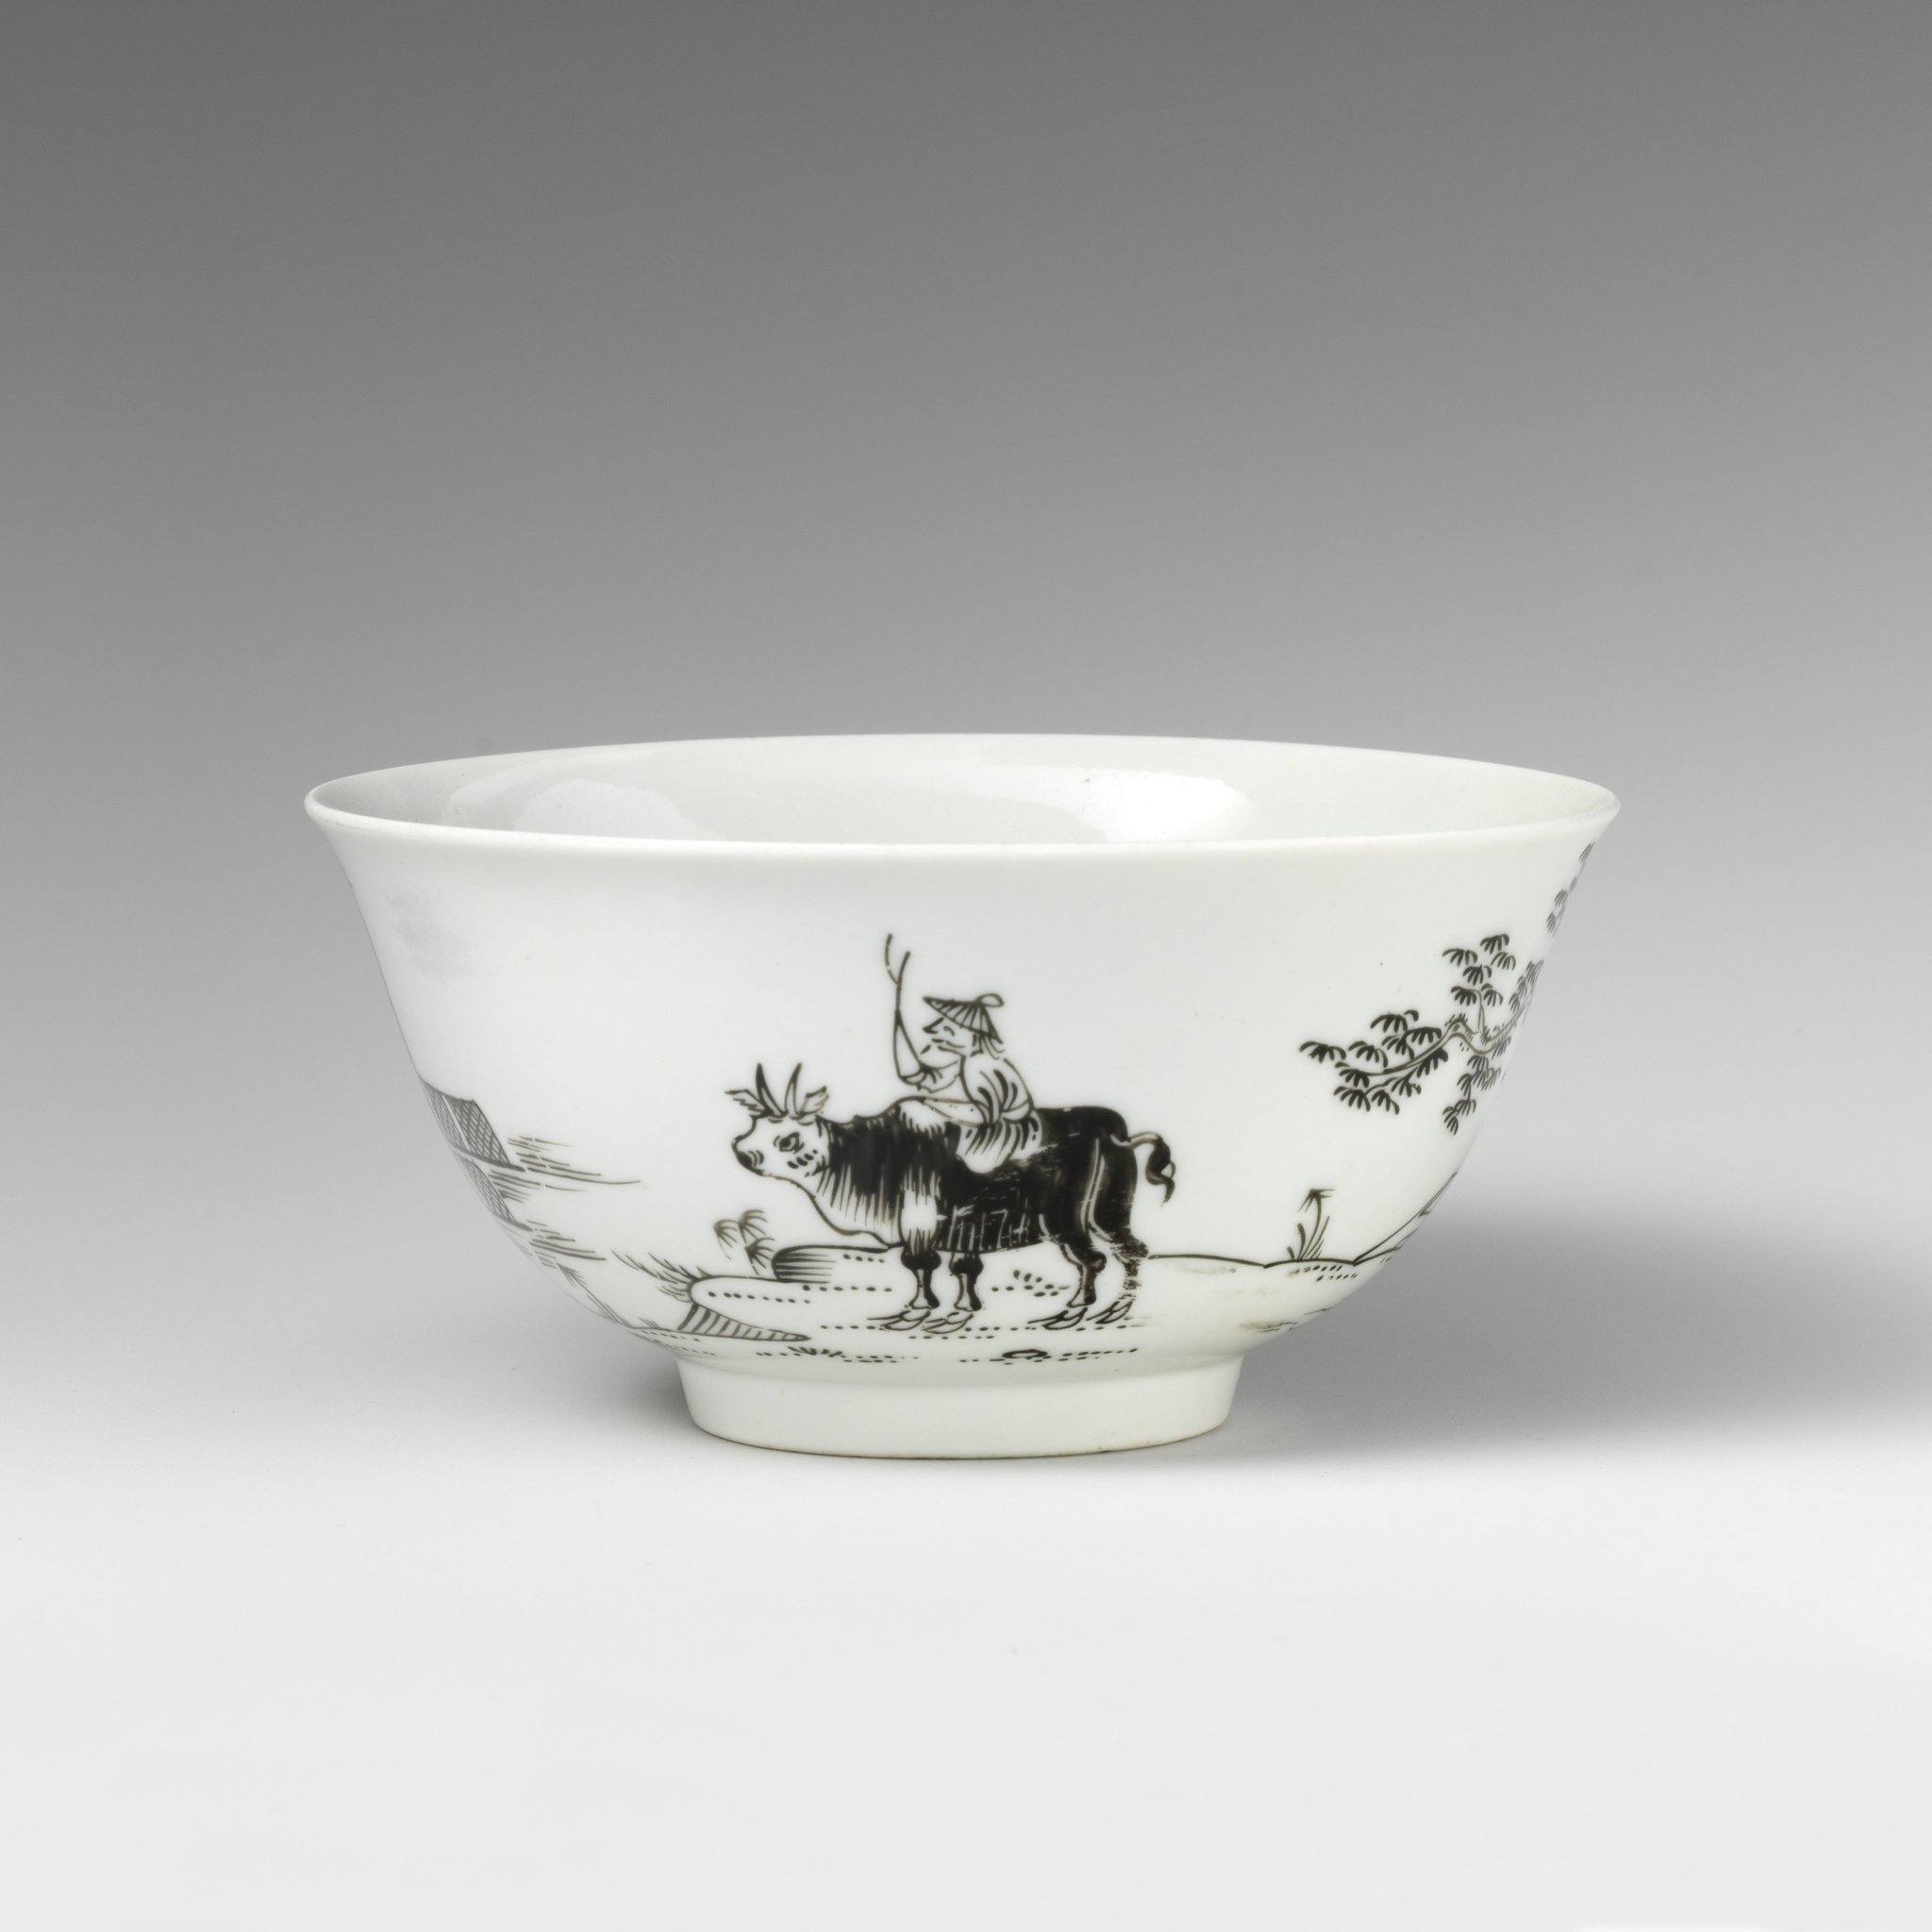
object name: bowl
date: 1701-1800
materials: soft paste porcelain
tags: men,cows